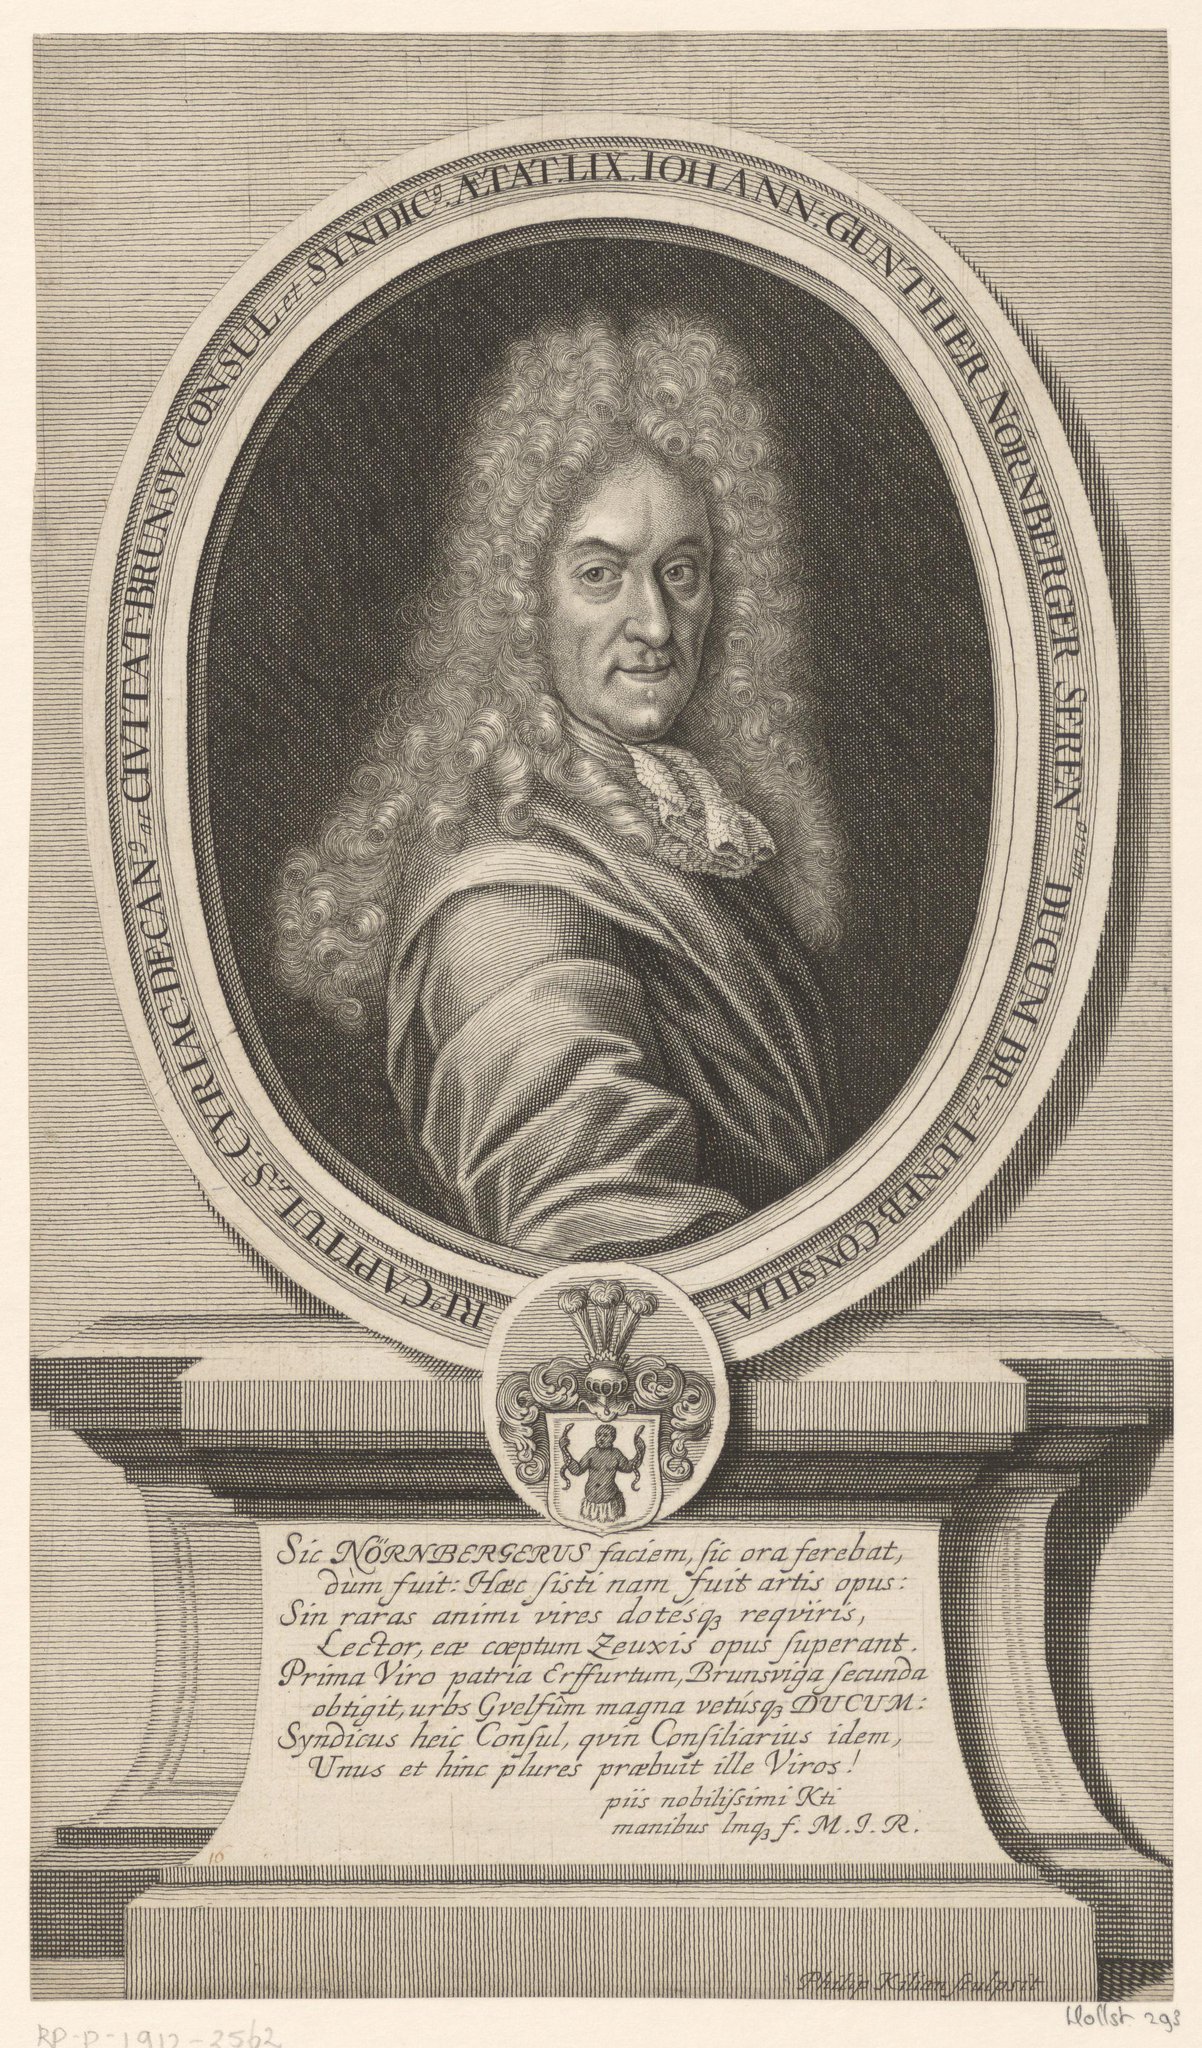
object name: print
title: Portret van Johann Gunther Nürnberger op 59-jarige leeftijd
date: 1689-1693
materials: paper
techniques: engraving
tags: mayor, mayor, burgomaster, historical persons, lawyer, attorney at law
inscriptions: collector's mark: Lugt 2228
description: Tekst in het Latijn in de omlijsting en op de sokkel.